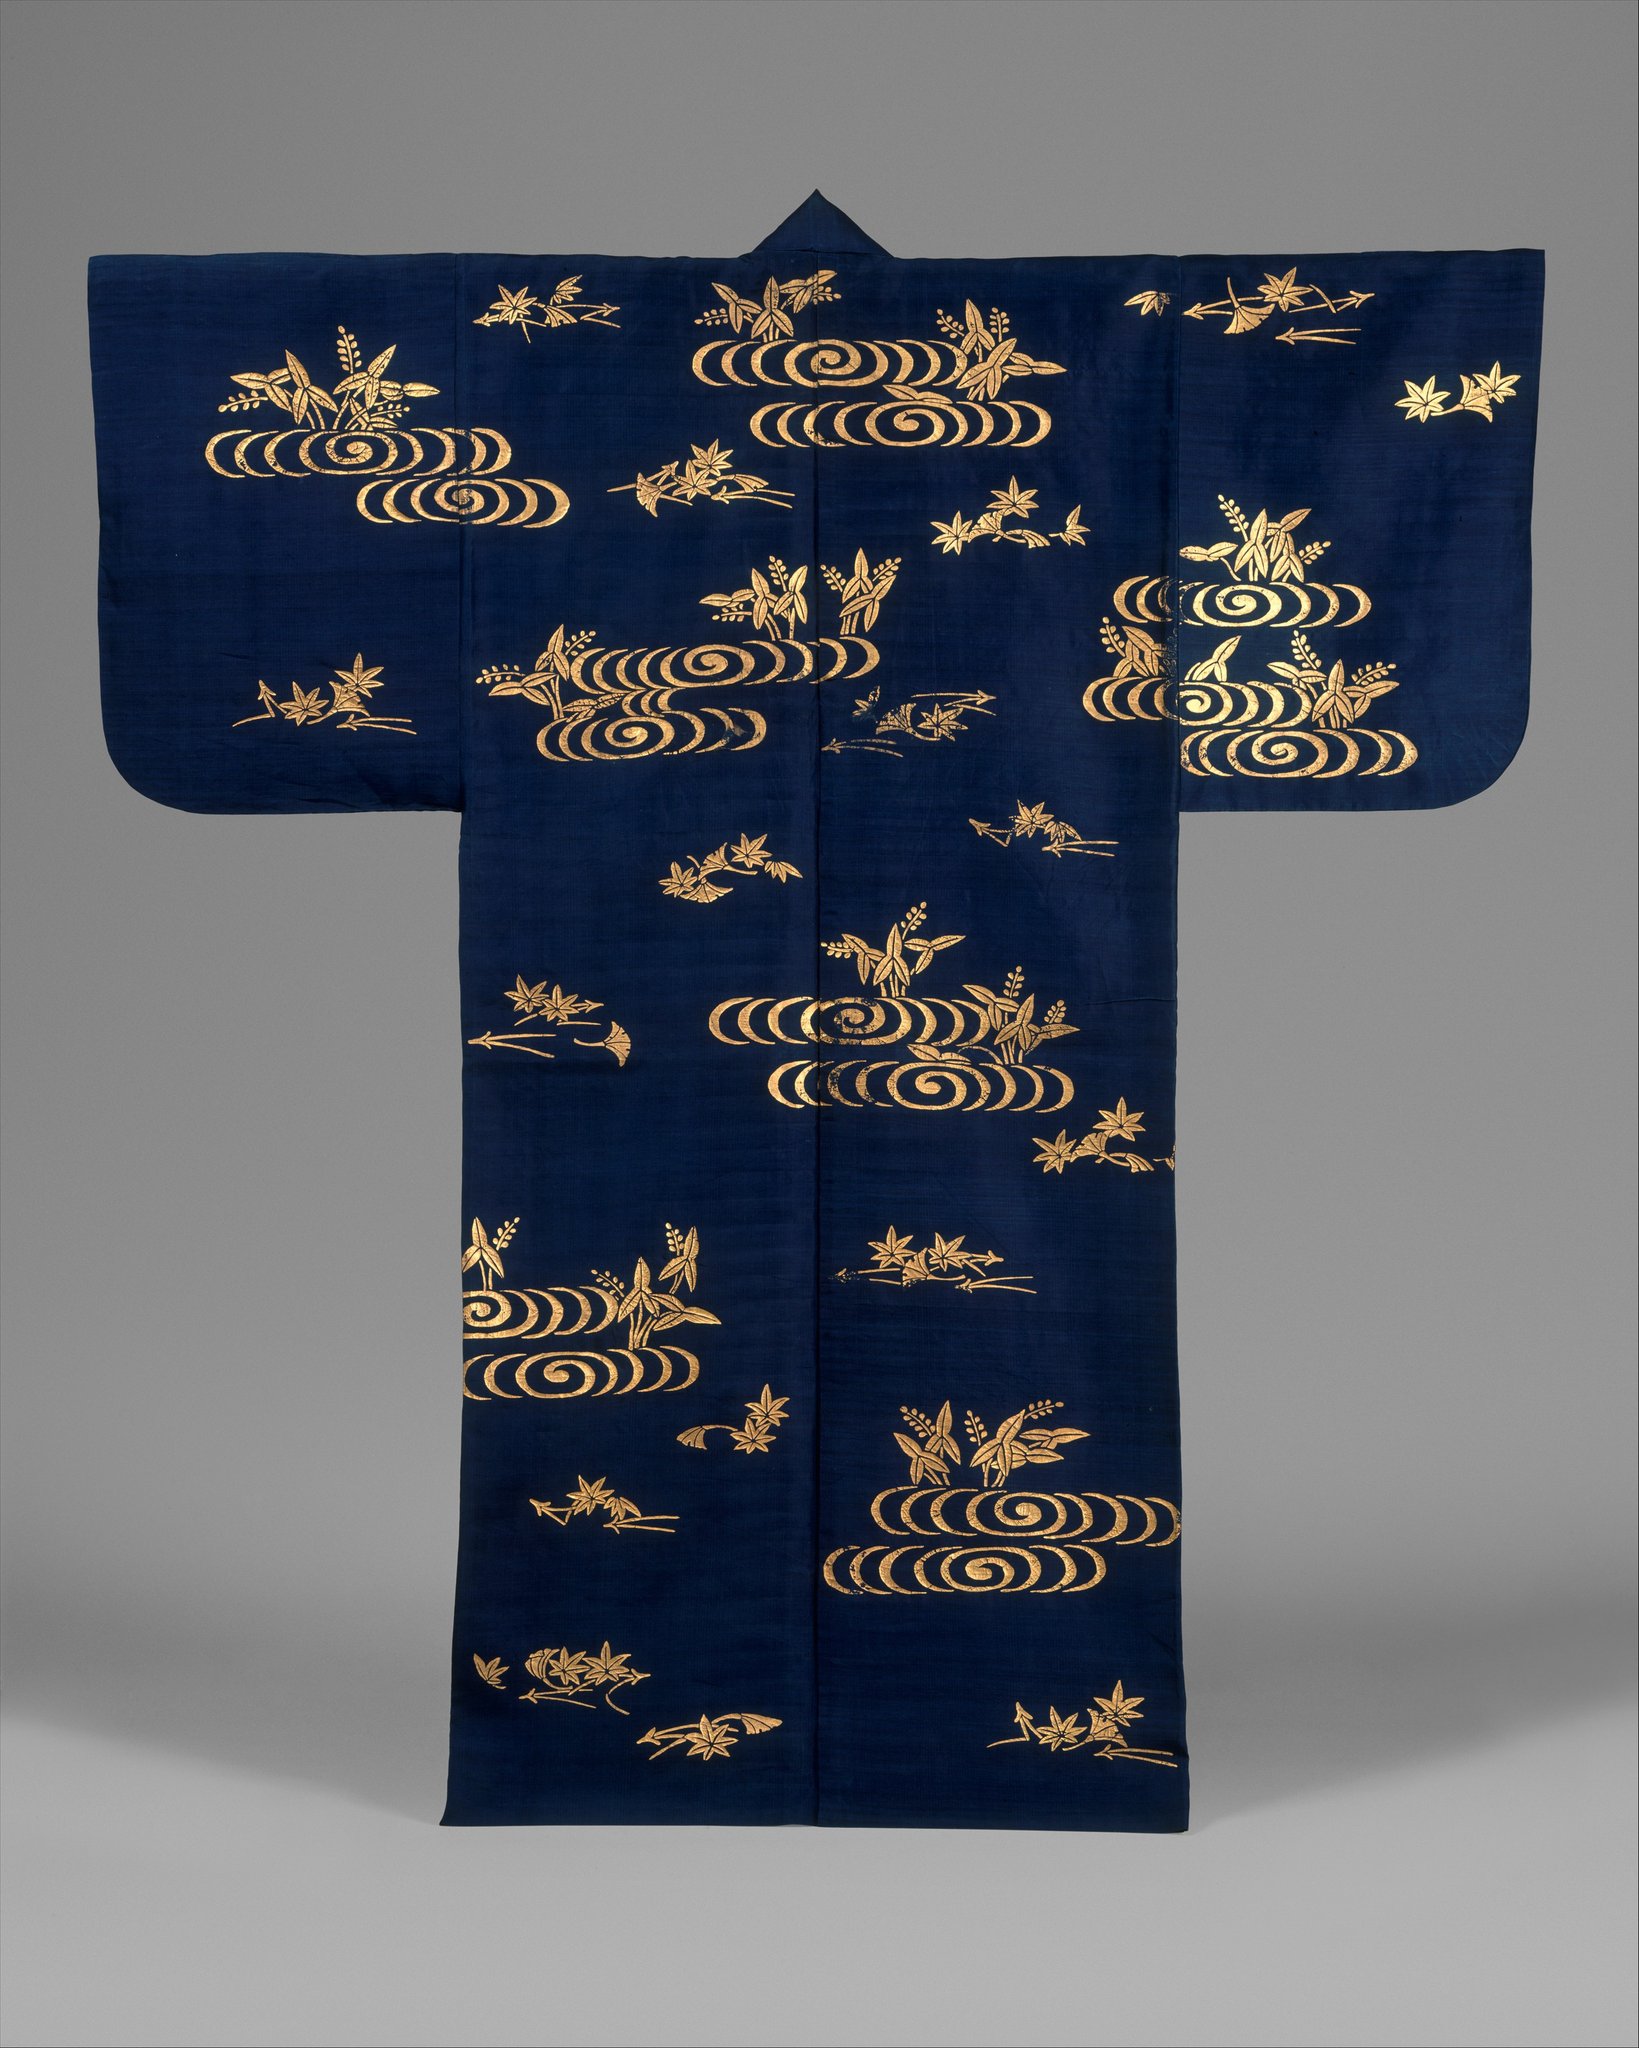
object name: noh costume surihaku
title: Noh Costume (Surihaku) with Water, Water Plants, and Leaves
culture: japanese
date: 1801-1900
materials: gold leaf, silk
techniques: weave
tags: plants